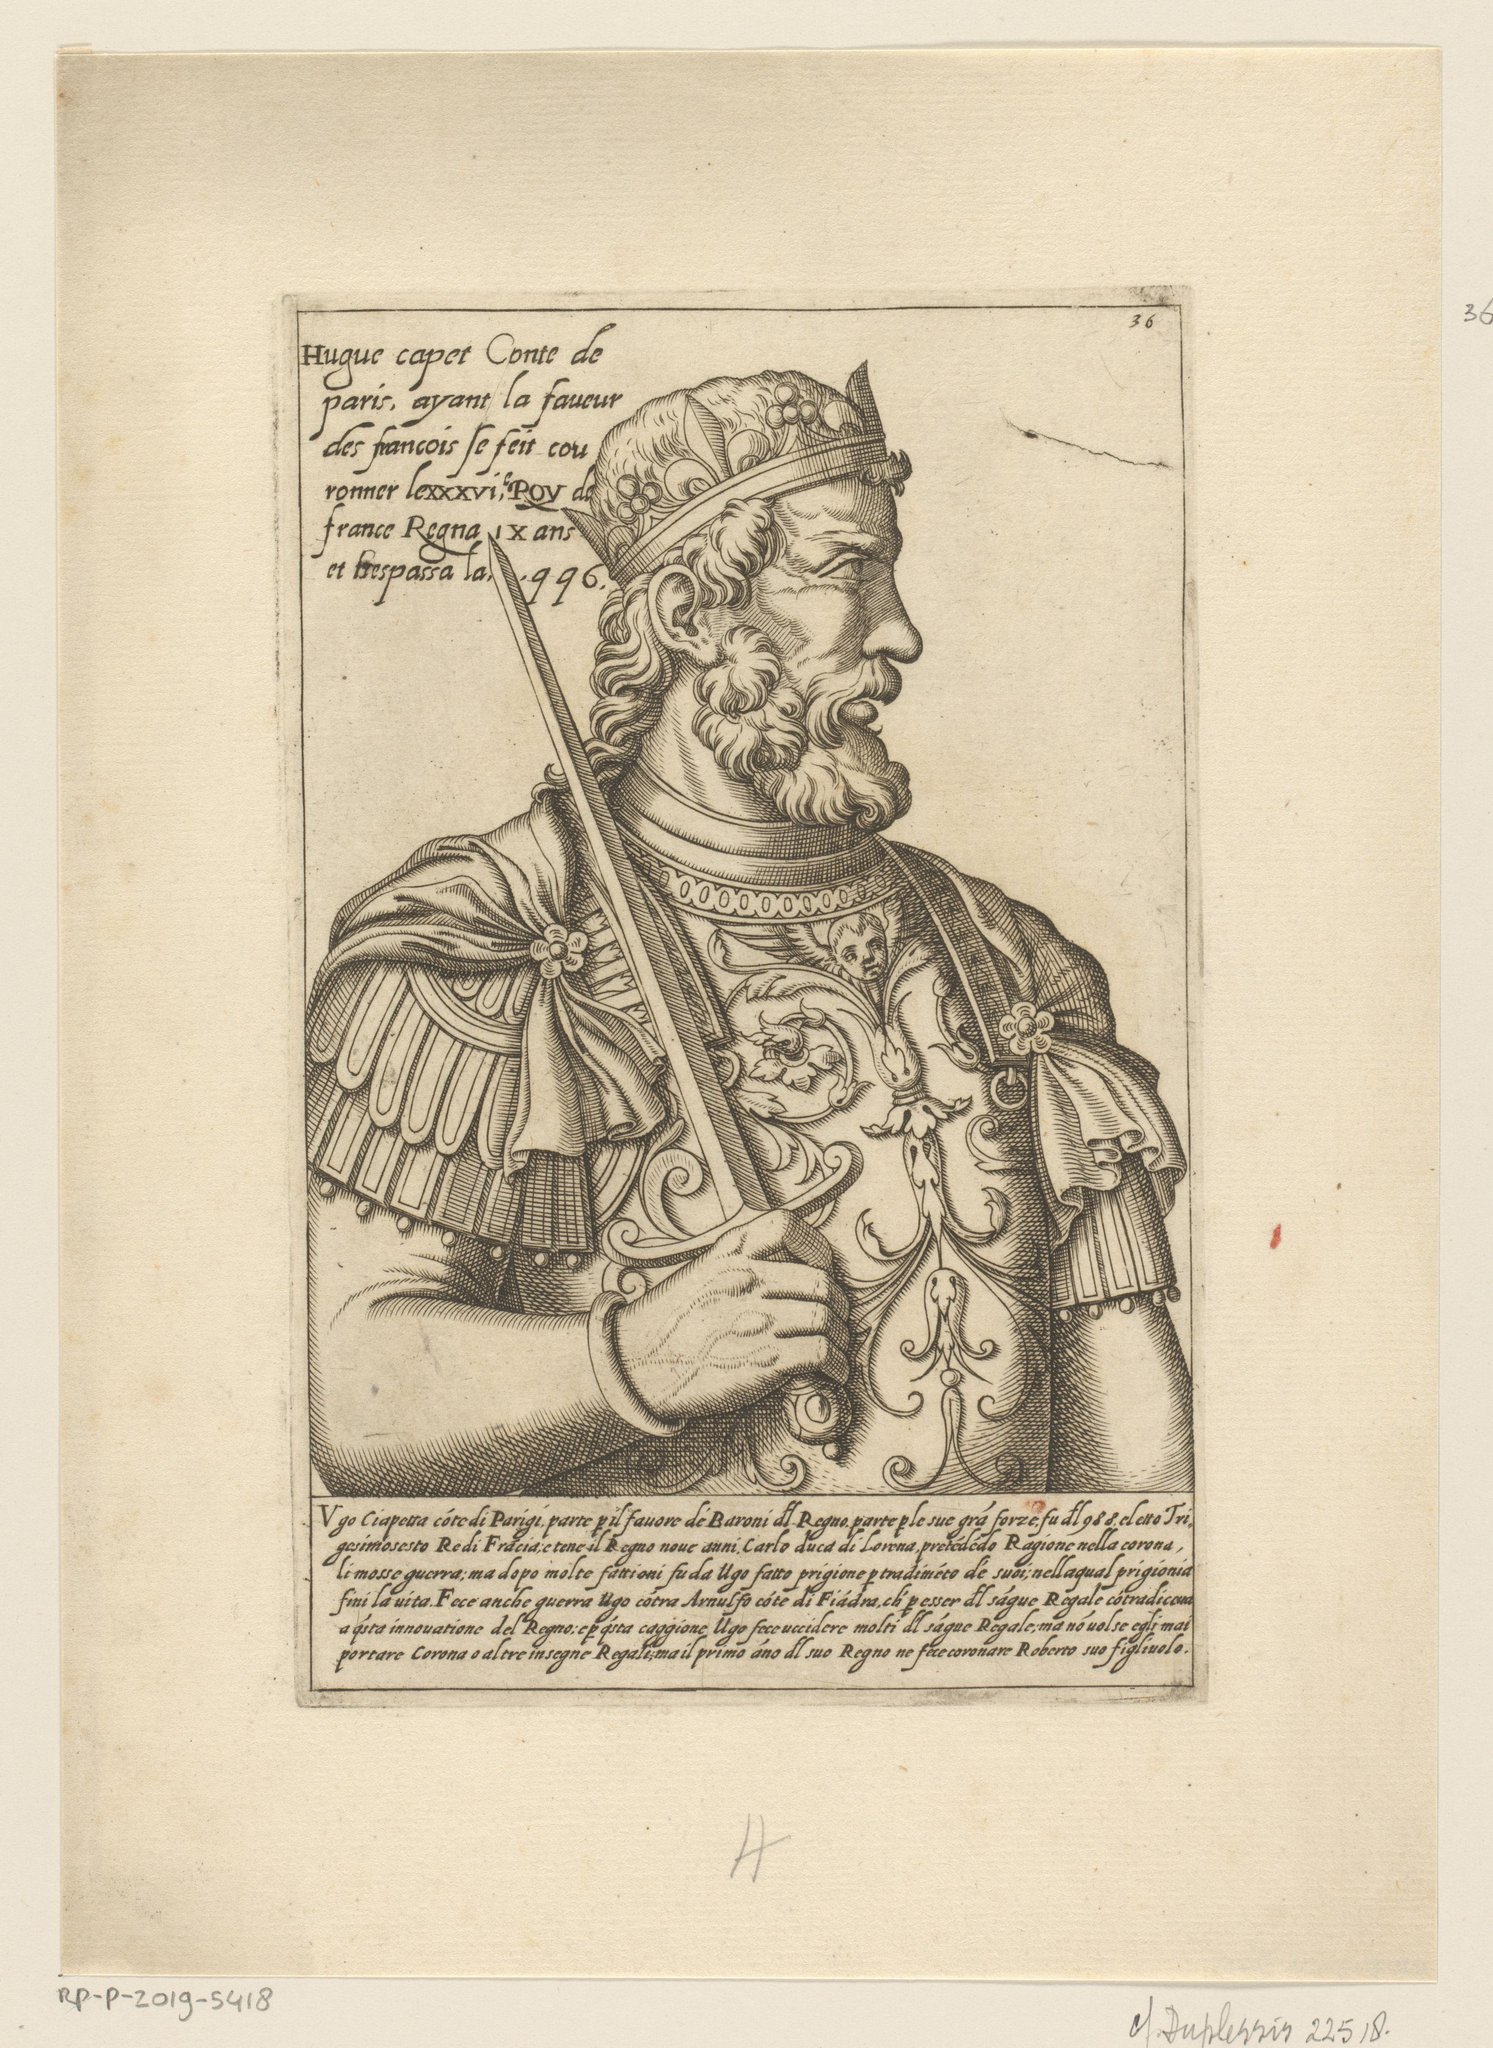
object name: book illustration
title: Portret van Hugo Capet, koning van Frankrijk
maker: Anonymous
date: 1588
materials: paper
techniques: engraving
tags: crown (symbol of sovereignty), historical persons, hacking and thrusting weapons: sword, king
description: Prent voor het eerst gebruikt in: Cronica Breve de i fatti illustri de're di Francia, con le loro effigie dal naturale cominciando da Faramondo (...). Venetië: Bernardo Giunti, 1588. Prent in ieder geval ook gebruikt in de editie van 1590 en mogelijk ook in een Franse uitgave van 1597.